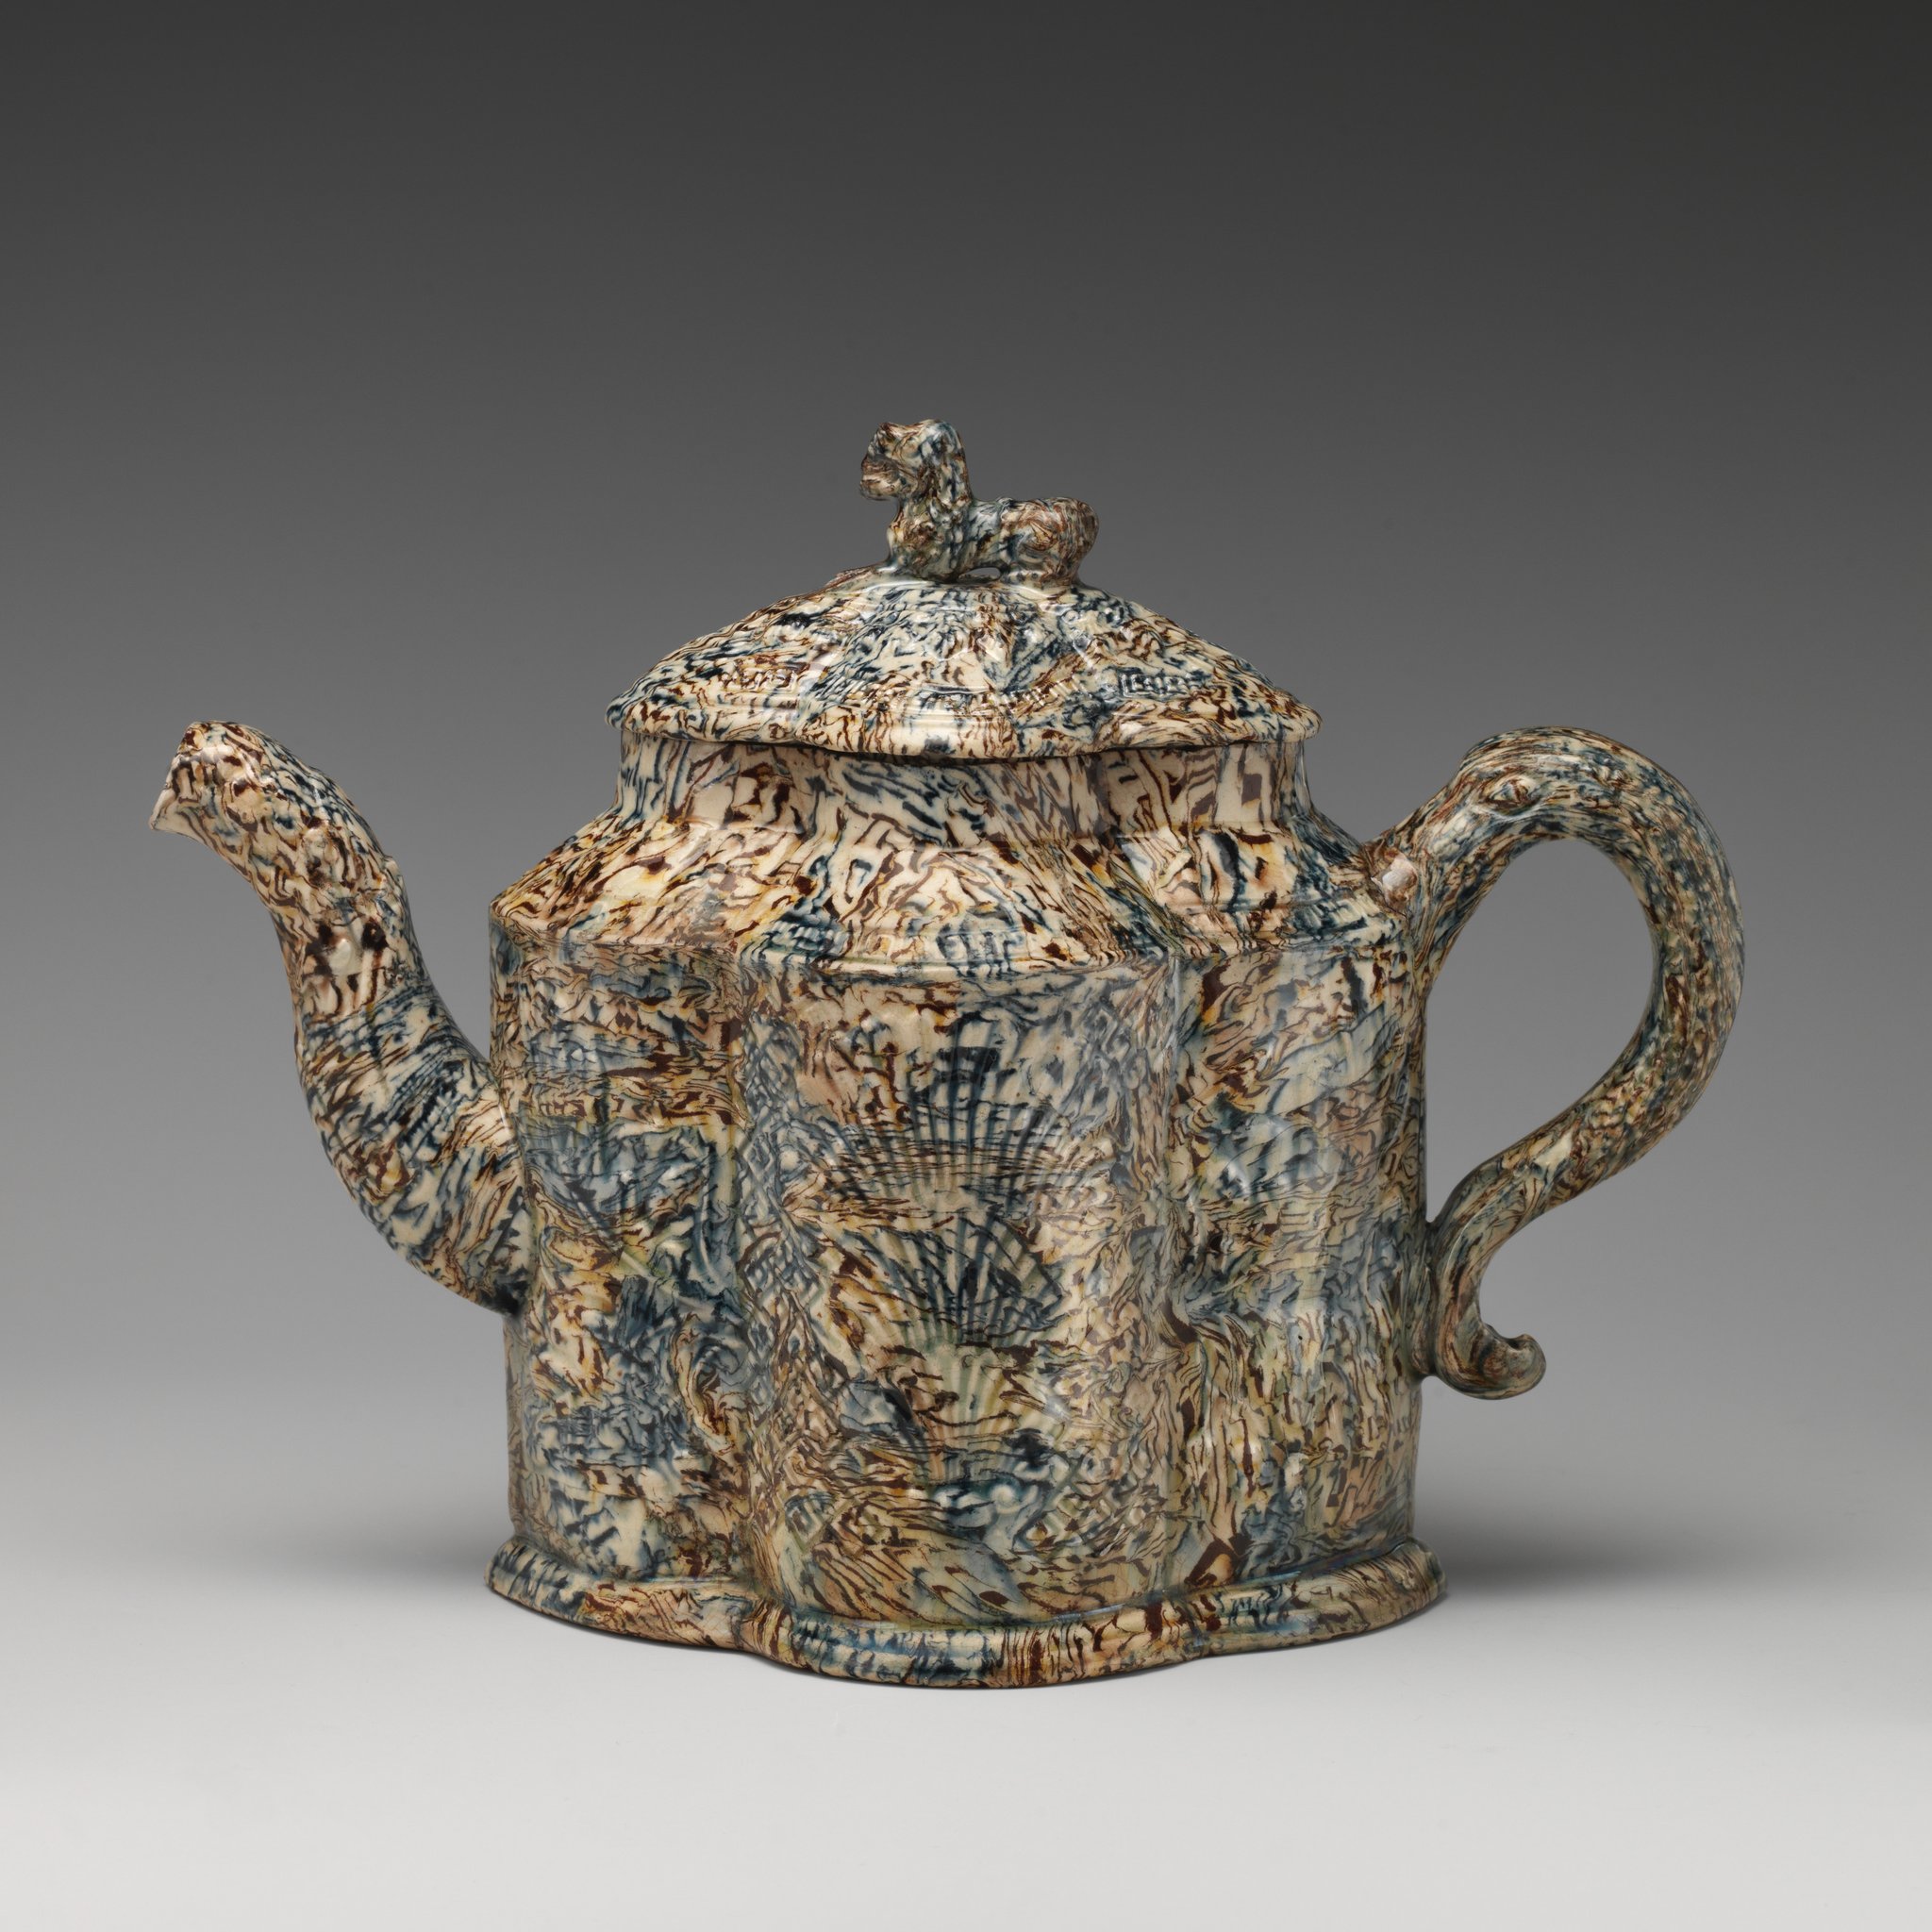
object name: teapot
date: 1750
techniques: glazing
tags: animals